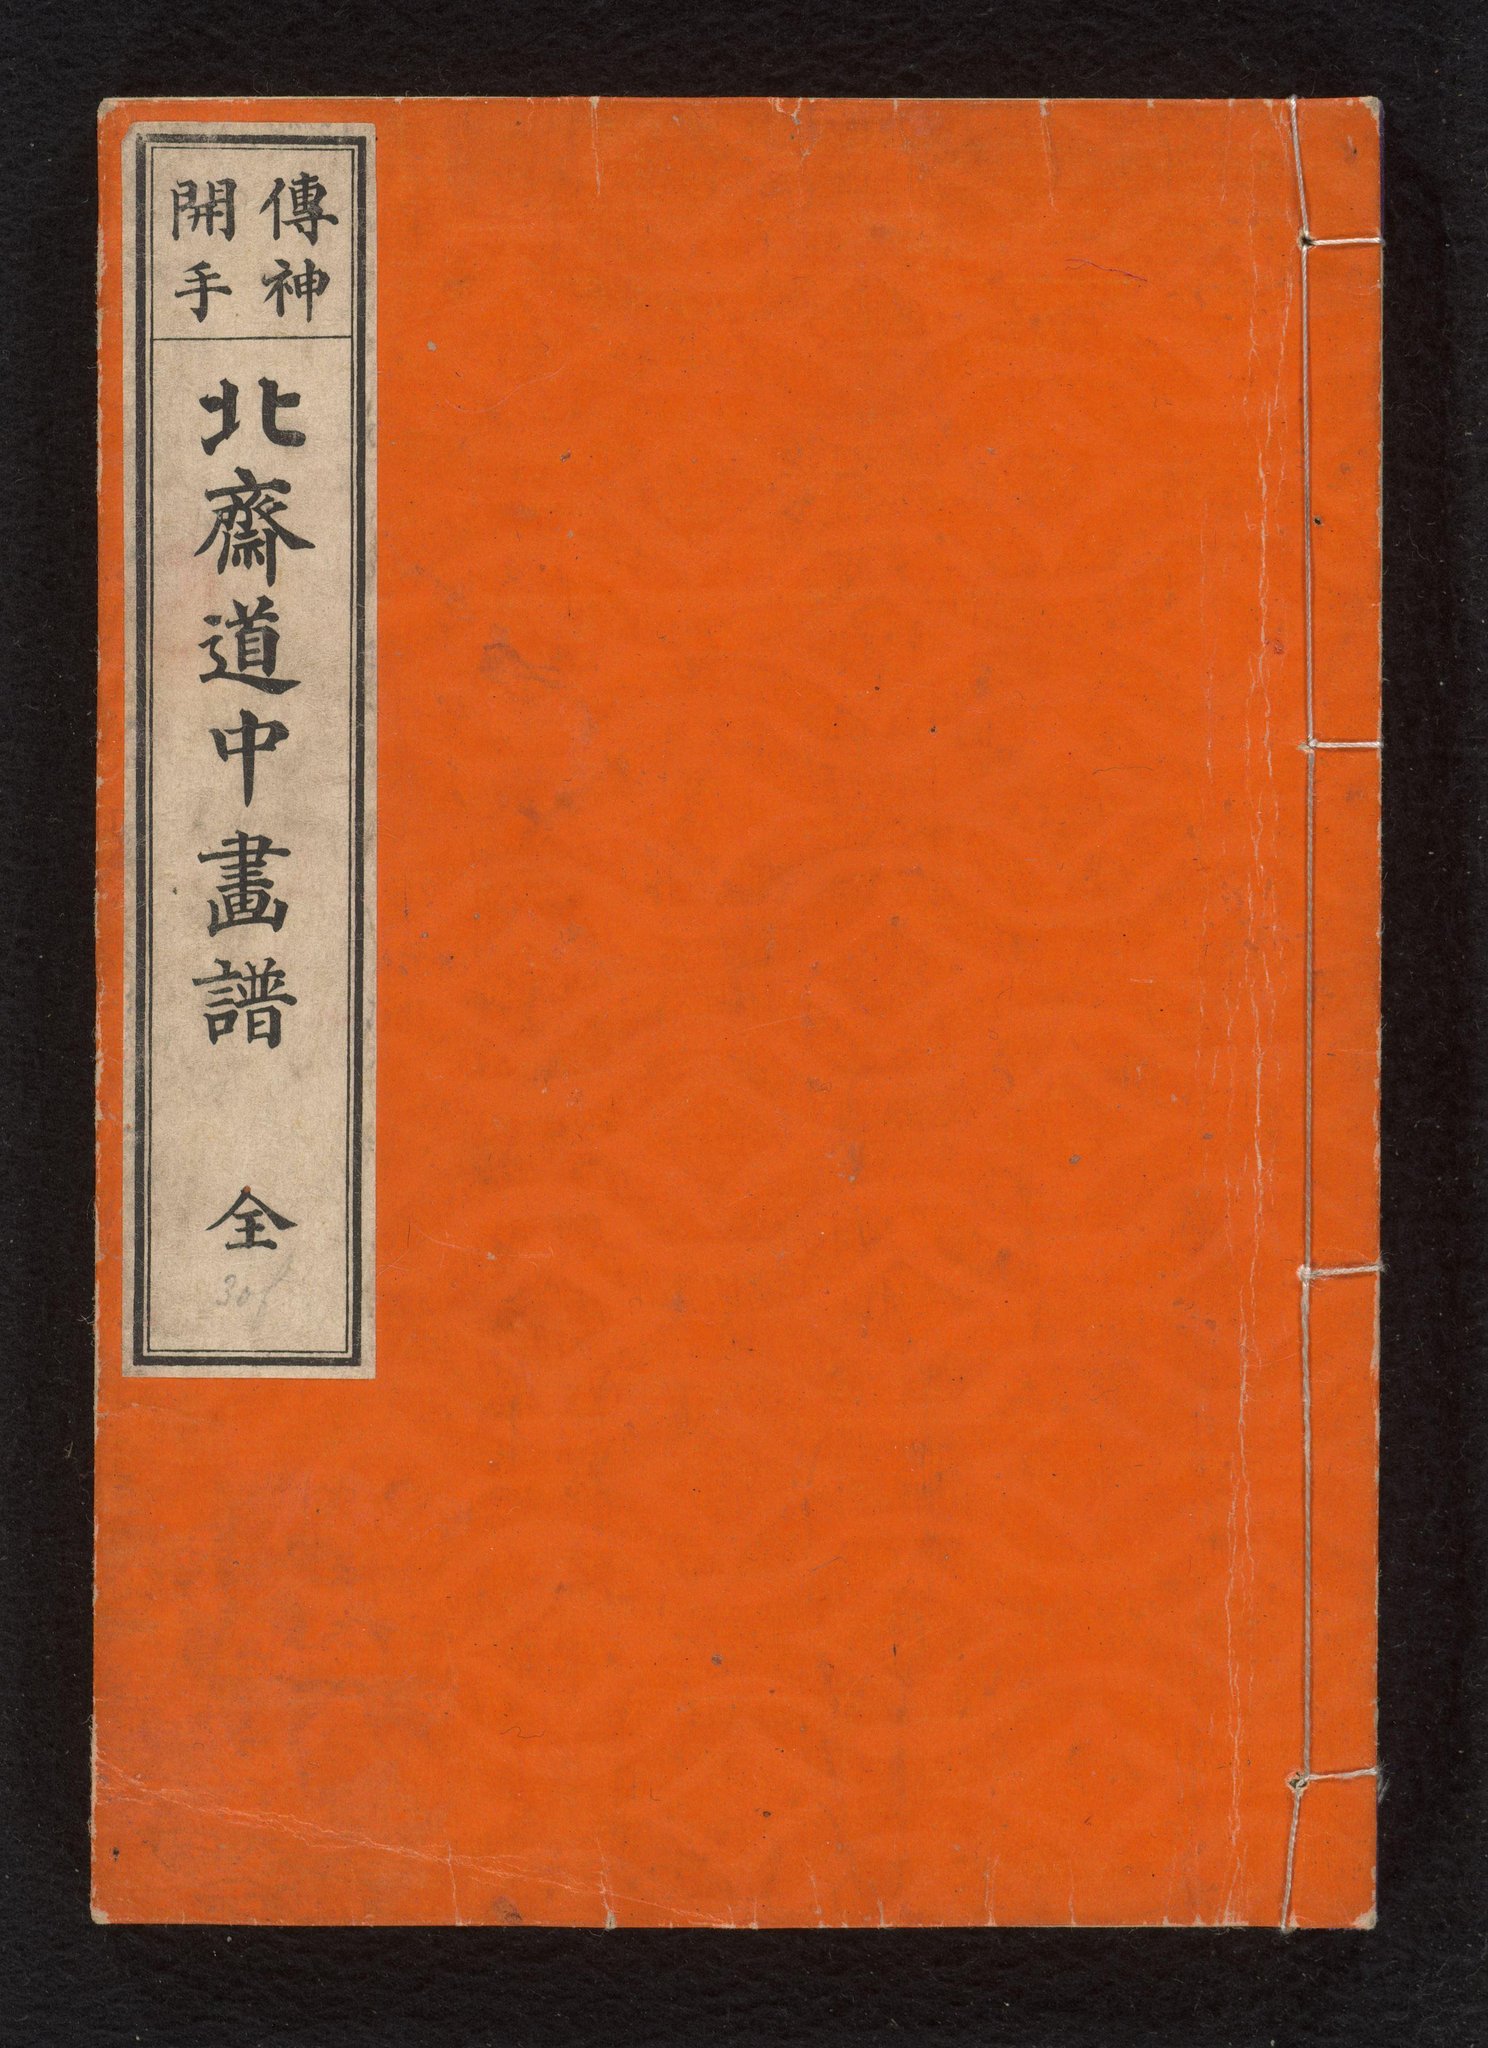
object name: book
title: Hokusai dochu gafu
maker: katsushika hokusai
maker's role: draughtsman, print maker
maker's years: 1760-1849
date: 1835-1878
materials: paper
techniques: woodcut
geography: nagoya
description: Geïllustreerd Japans boekje van Hokusai met afbeeldingen van reizigers en bezienswaardigheden langs de Tokaido. Herdruk van de eerste editie uit 1835.